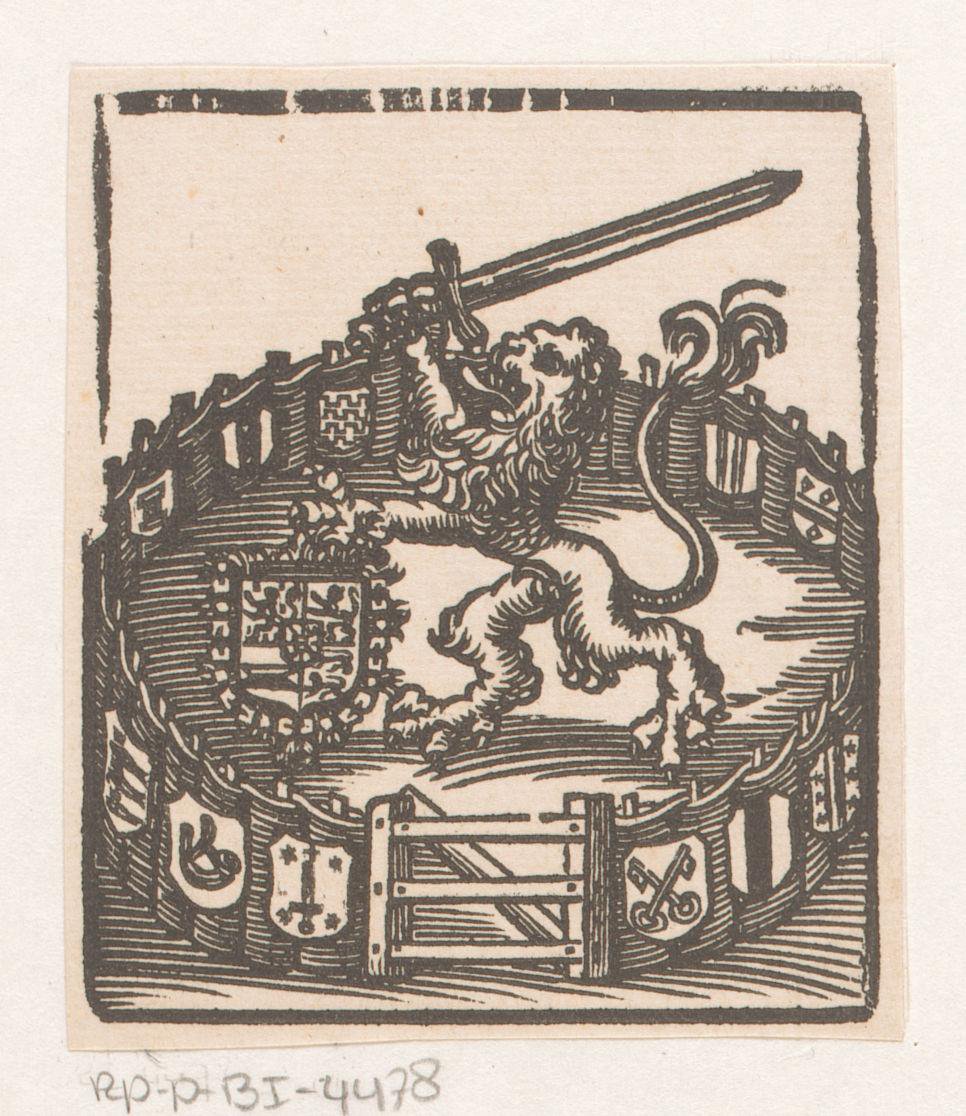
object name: print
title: Vignet met de Nederlandse Leeuw met een zwaard in een omsloten tuin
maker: Anonymous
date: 1600-1699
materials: paper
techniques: woodcut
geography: netherlands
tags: fenced or walled garden; 'hortus conclusus', vignette, symbols of particular nations, states, districts, etc.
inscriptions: collector's mark: Lugt 240